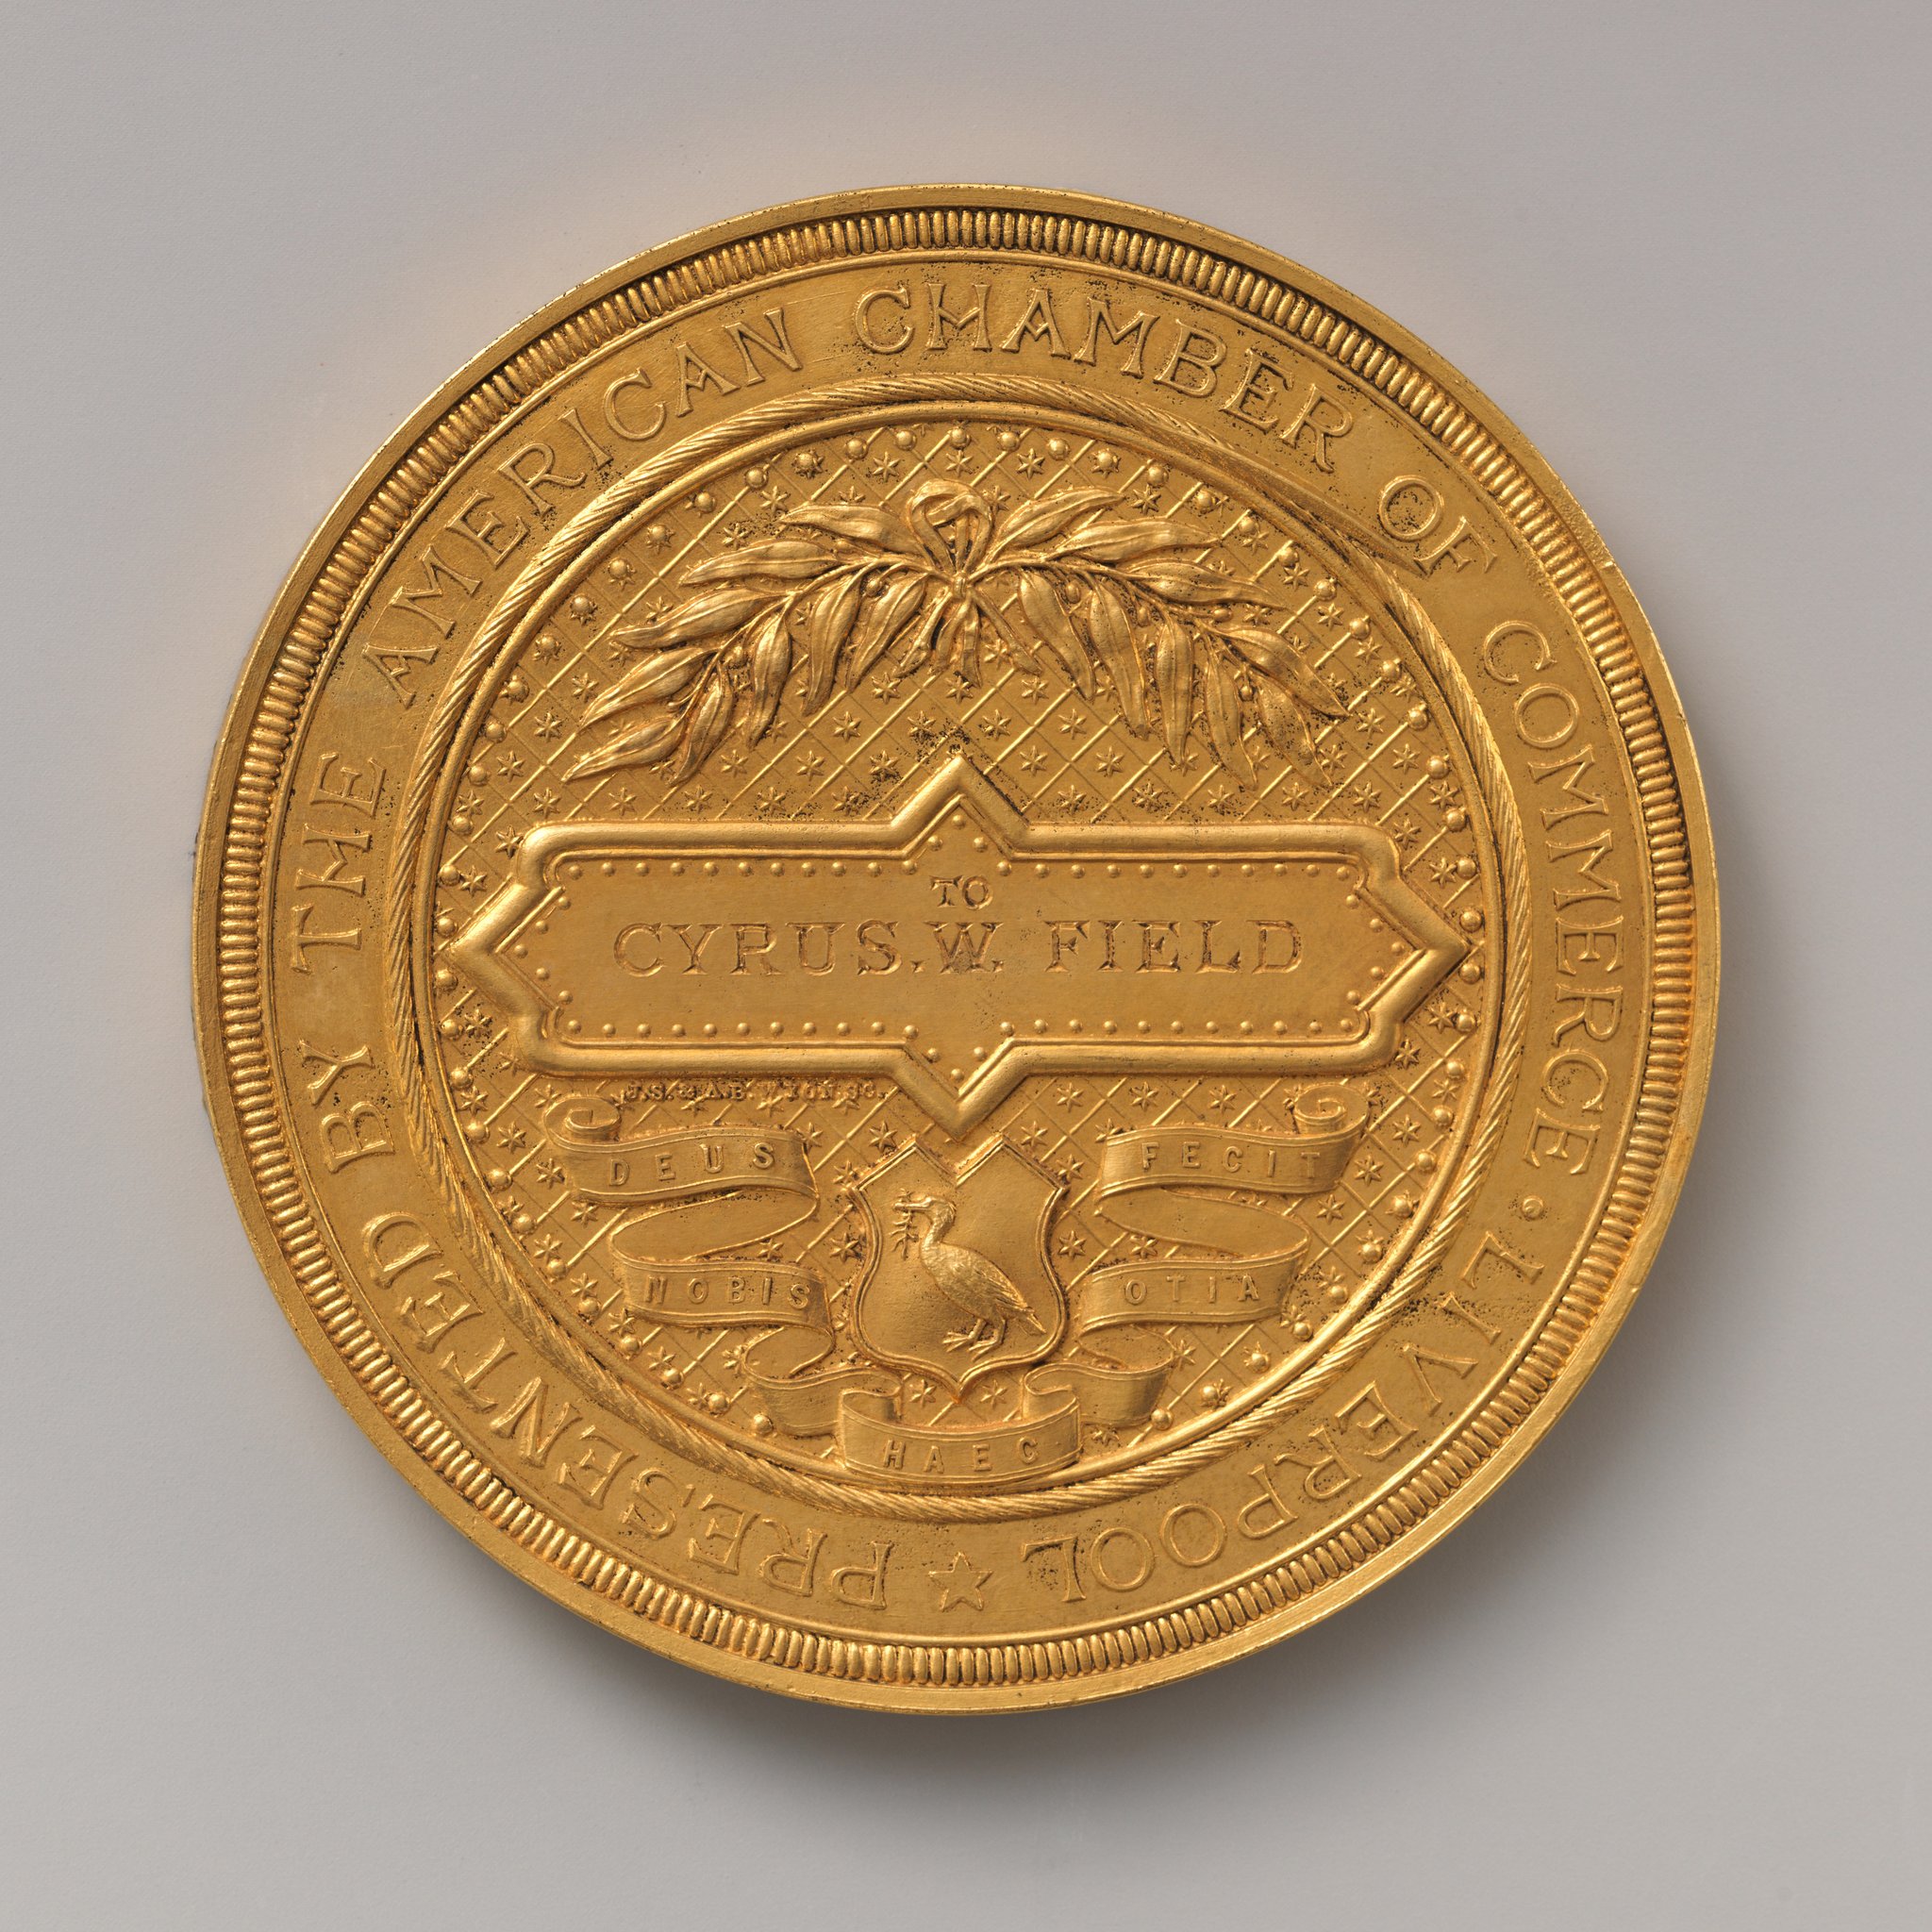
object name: medal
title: To Cyrus W. Field from the American Chamber of Commerce, Liverpool, on the Laying of the Atlantic Cable, 1866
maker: joseph shepherd wyon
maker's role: artist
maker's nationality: british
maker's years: 1836-1873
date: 1866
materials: gilt copper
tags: birds,transatlantic cable